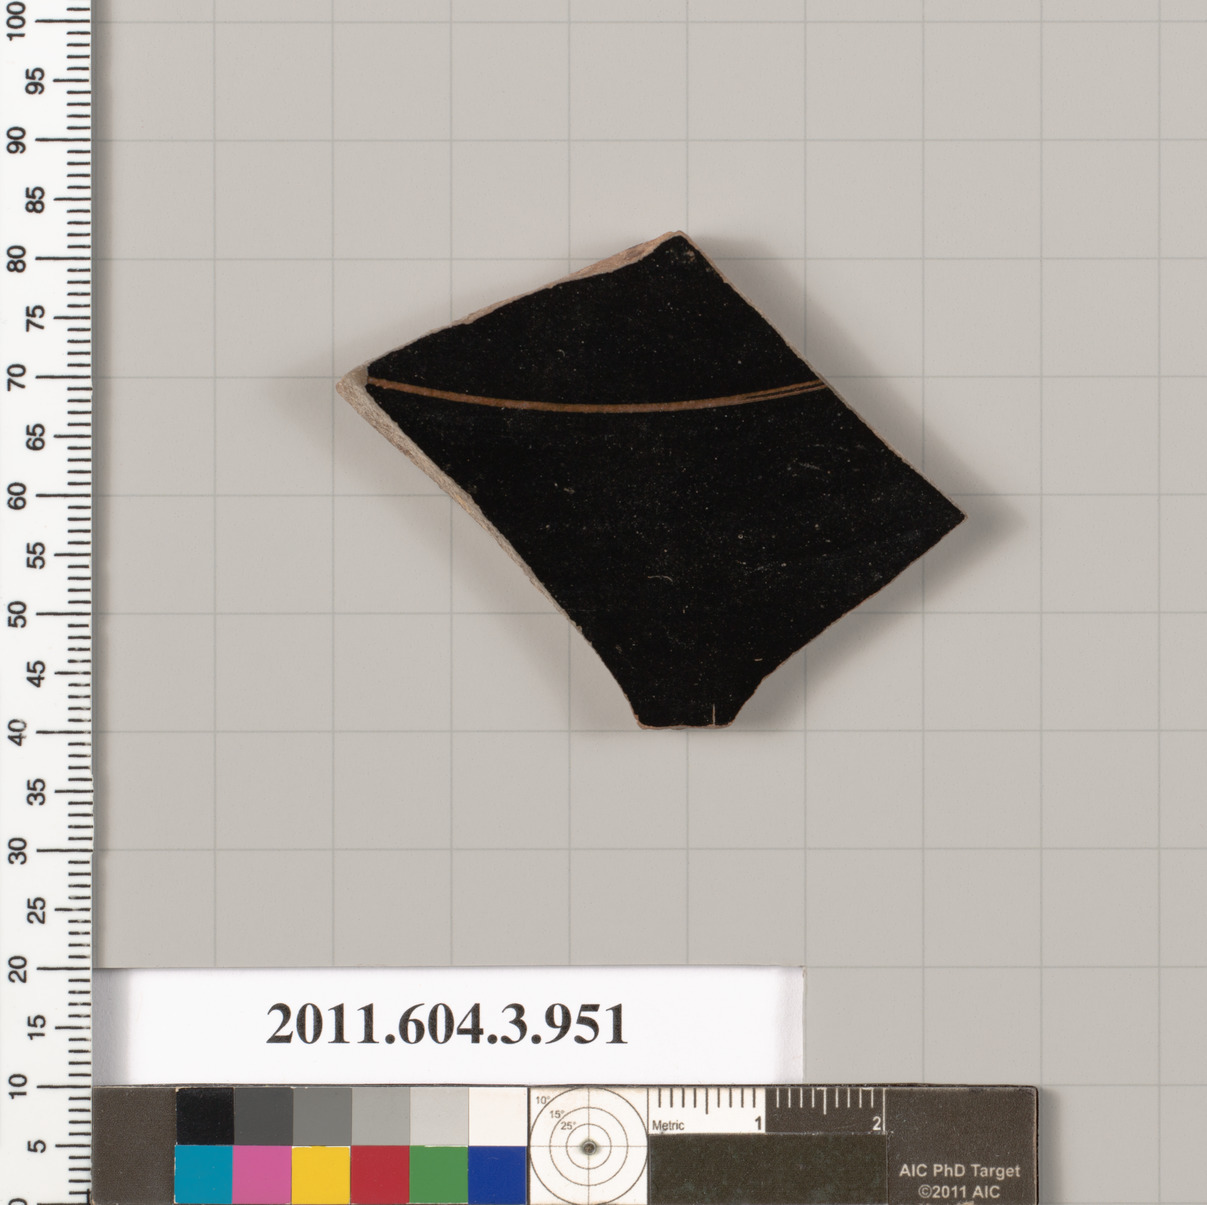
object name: lekanis lid fragment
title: Terracotta fragment of a lekanis lid (covered dish)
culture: greek, attic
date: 600-501 BCE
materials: terracotta